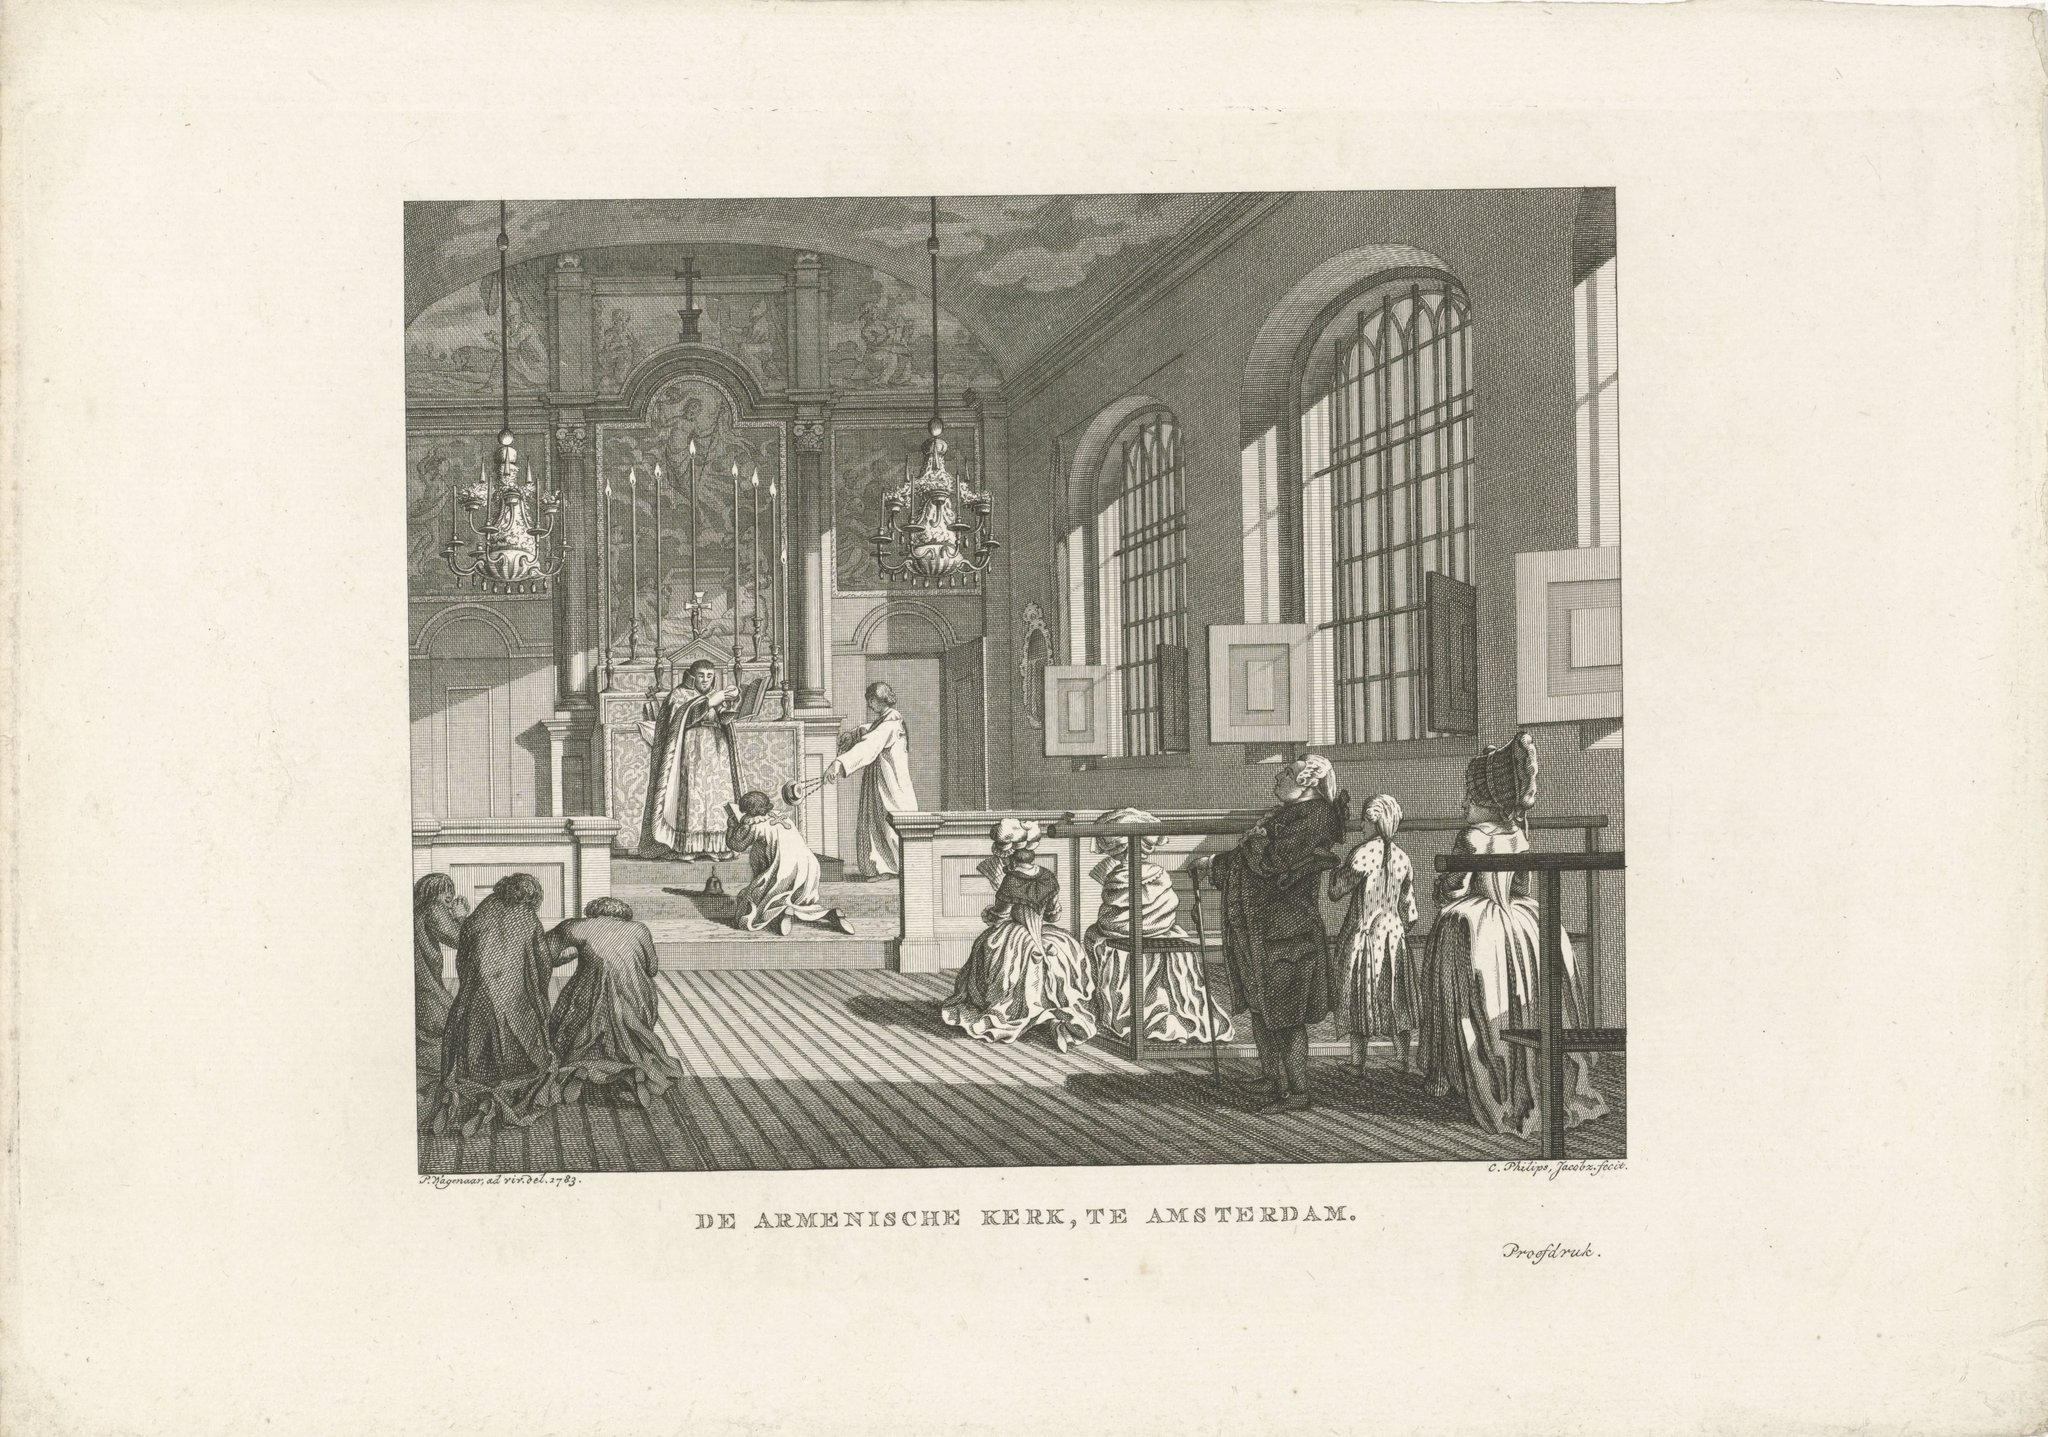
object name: print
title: De Armenische Kerk, te Amsterdam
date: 1783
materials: paper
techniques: etching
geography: amsterdam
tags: incensation of the altar, the early christian churches, e.g. armenians, copts, syrians, offerings of bread and wine ~ holy mass, interior of church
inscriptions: collector's mark: Lugt 2228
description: Interieur van de Armeense kerk te Amsterdam, waarin een priester de mis opdraagt.